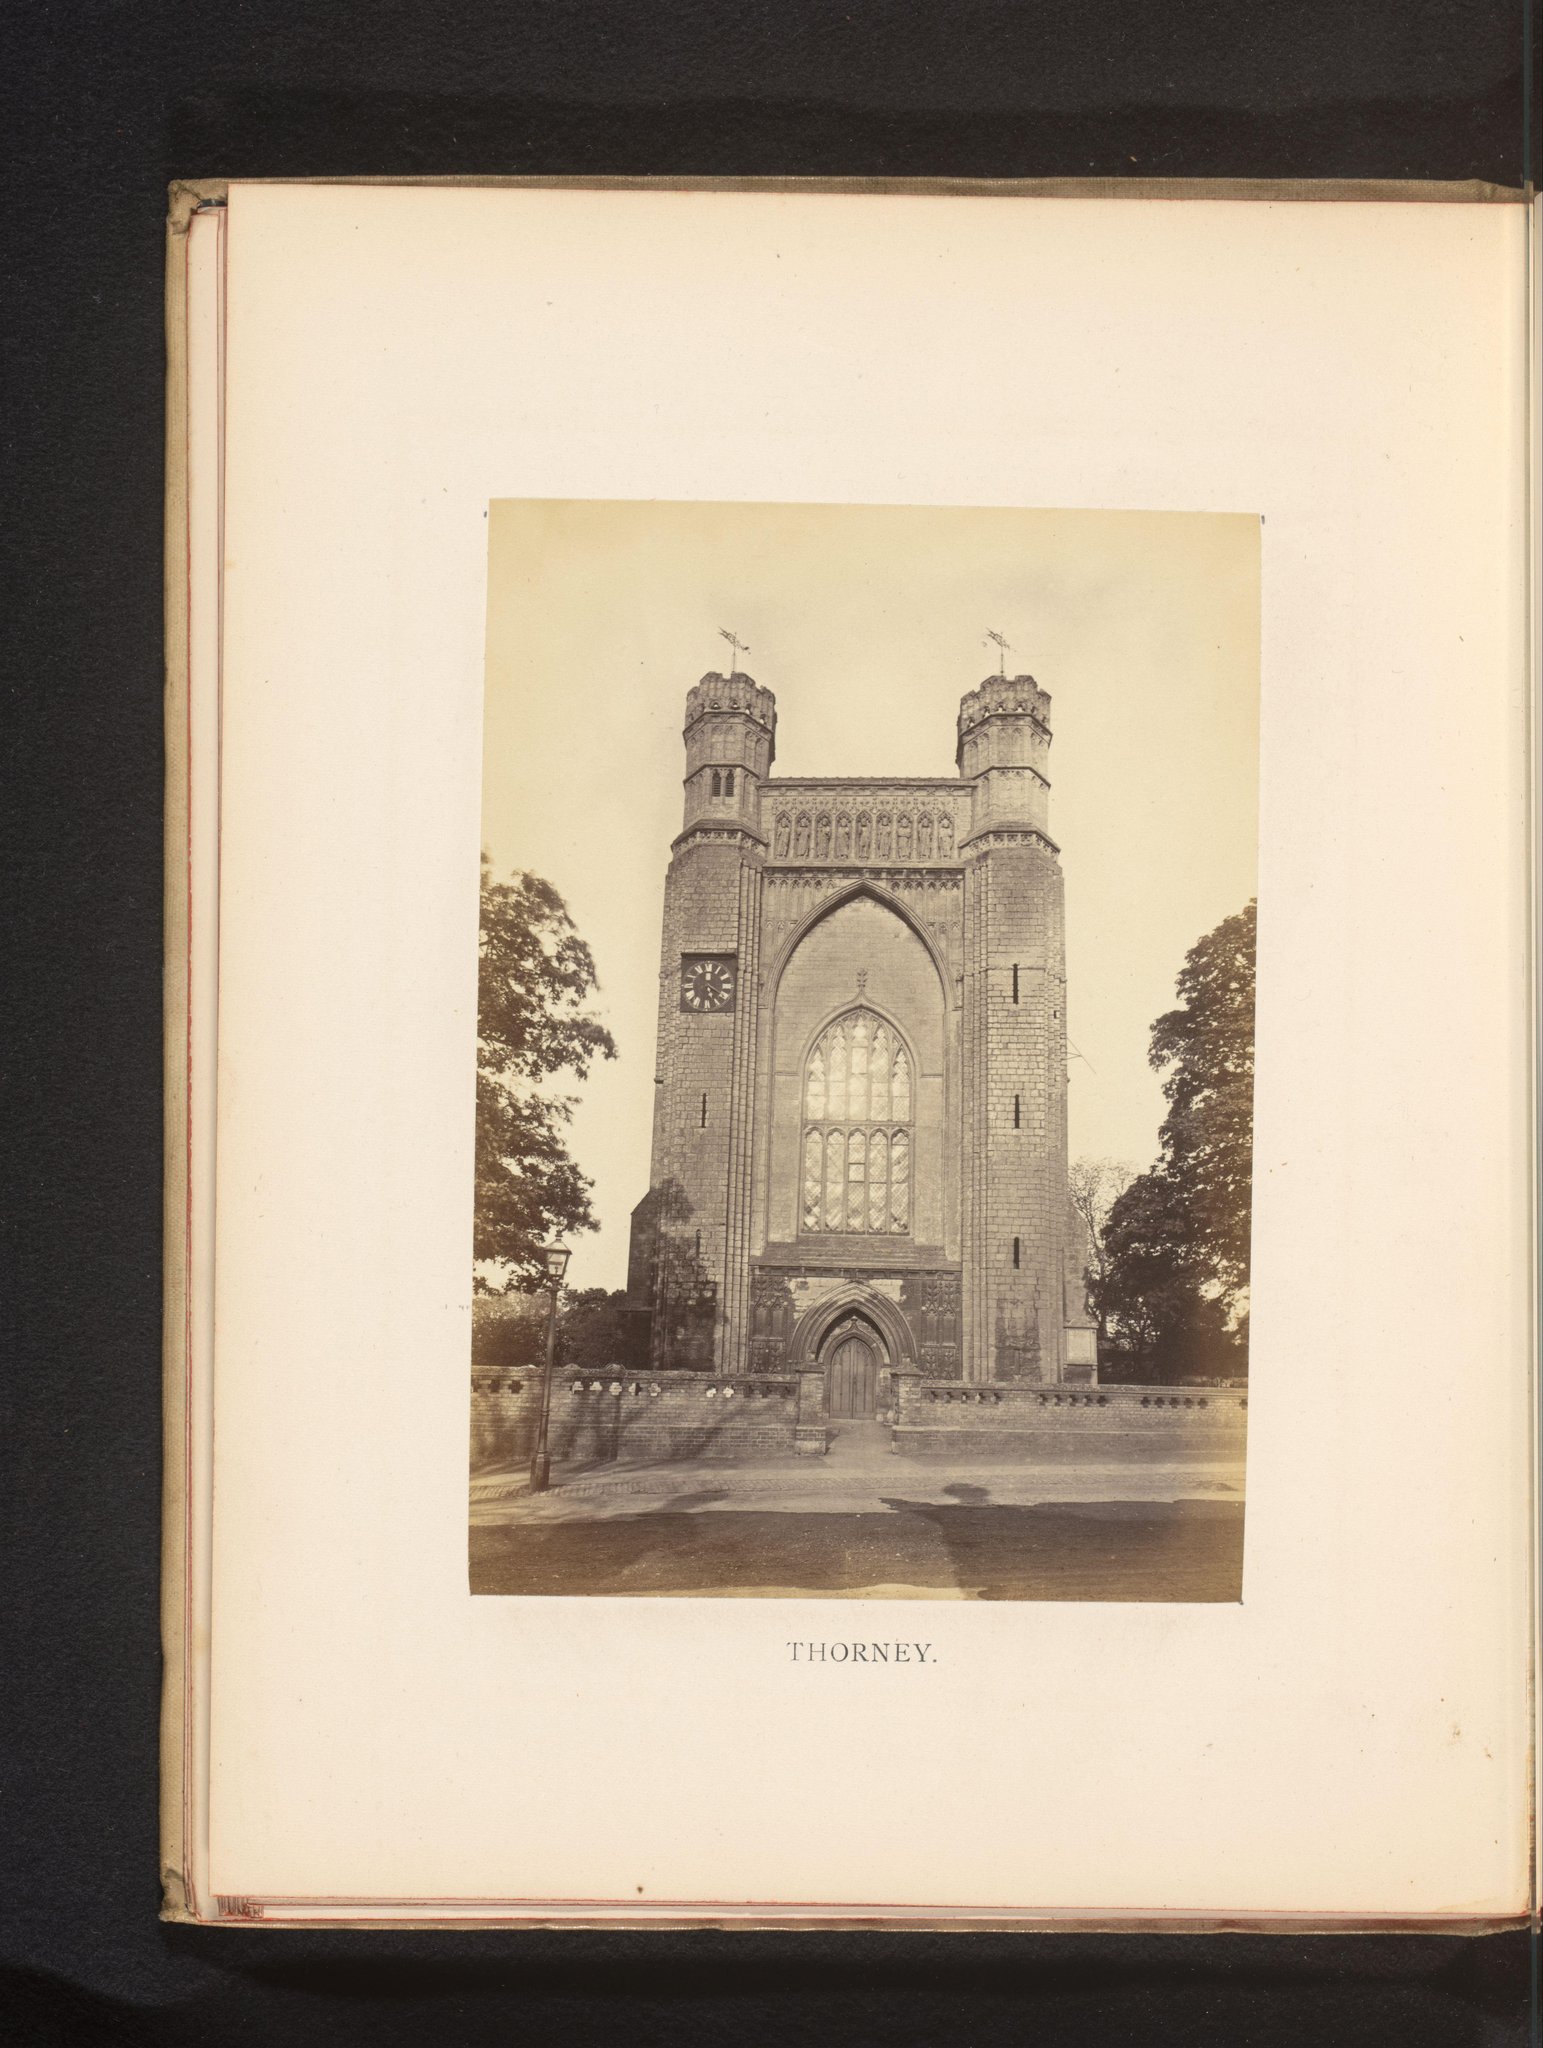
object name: page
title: Thorney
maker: Anonymous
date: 1858-1869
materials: photographic support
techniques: albumen print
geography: thorney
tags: church (exterior), façade (of house or building)